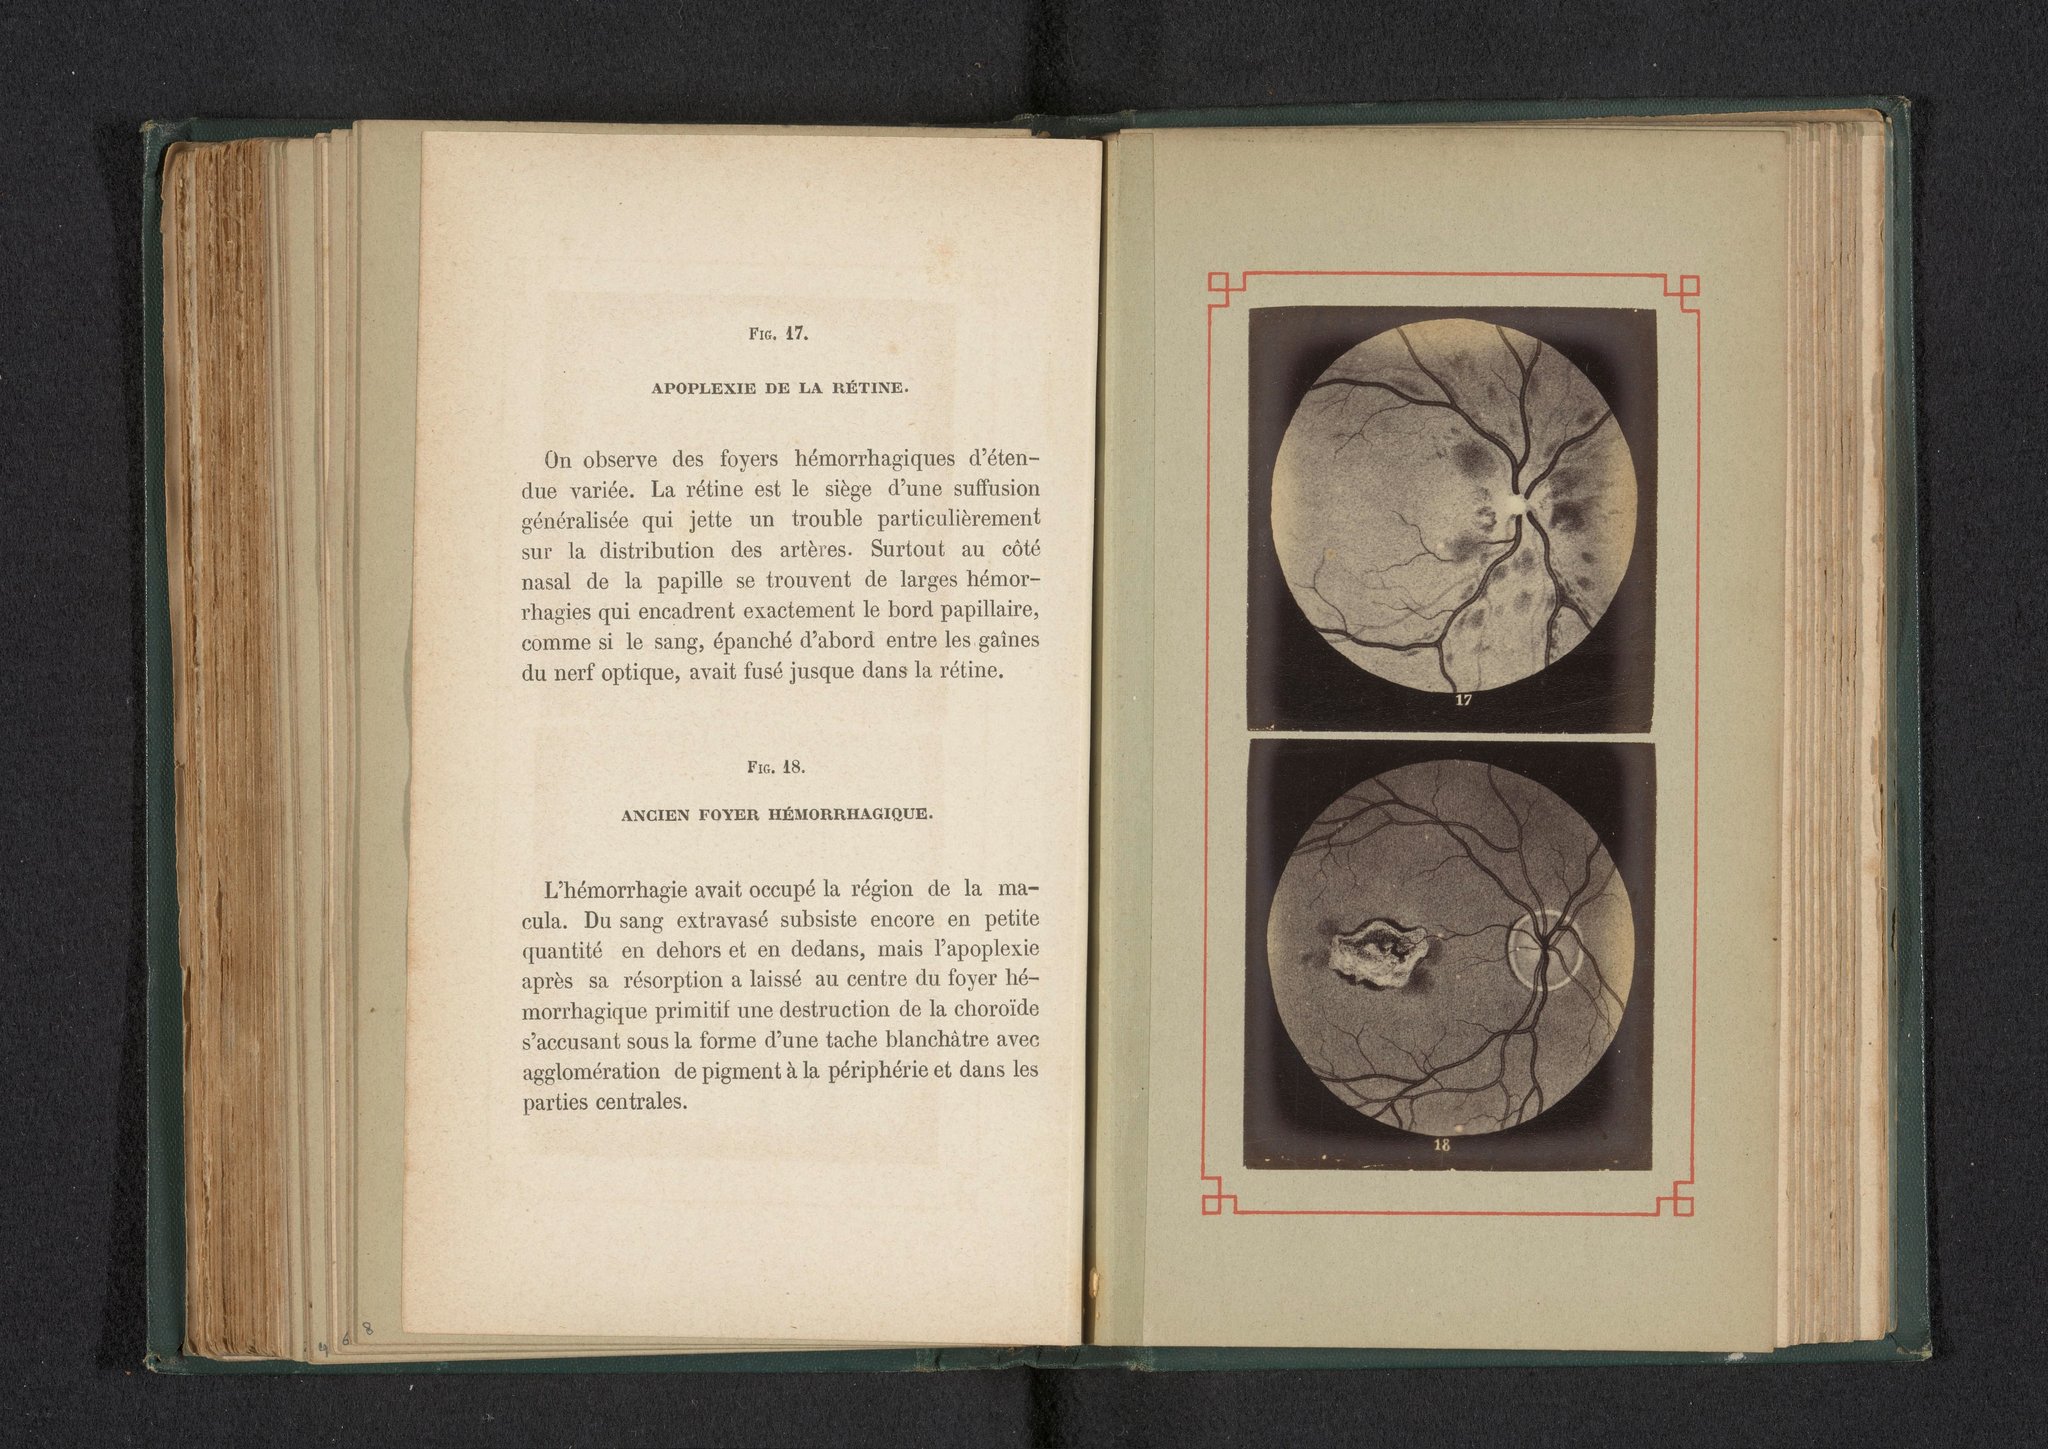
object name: page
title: Fotoreproductie van twee anatomische tekeningen van een bloeding bij het netvlies en een bloeding in het oog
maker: Anonymous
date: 1871-1881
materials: photographic support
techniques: albumen print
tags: anatomy (non-medical), eyes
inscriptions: inscription: ‘Fig. 17. Apoplexie de la rétine. Fig. 18. Ancien foyer hémorrhagique.’